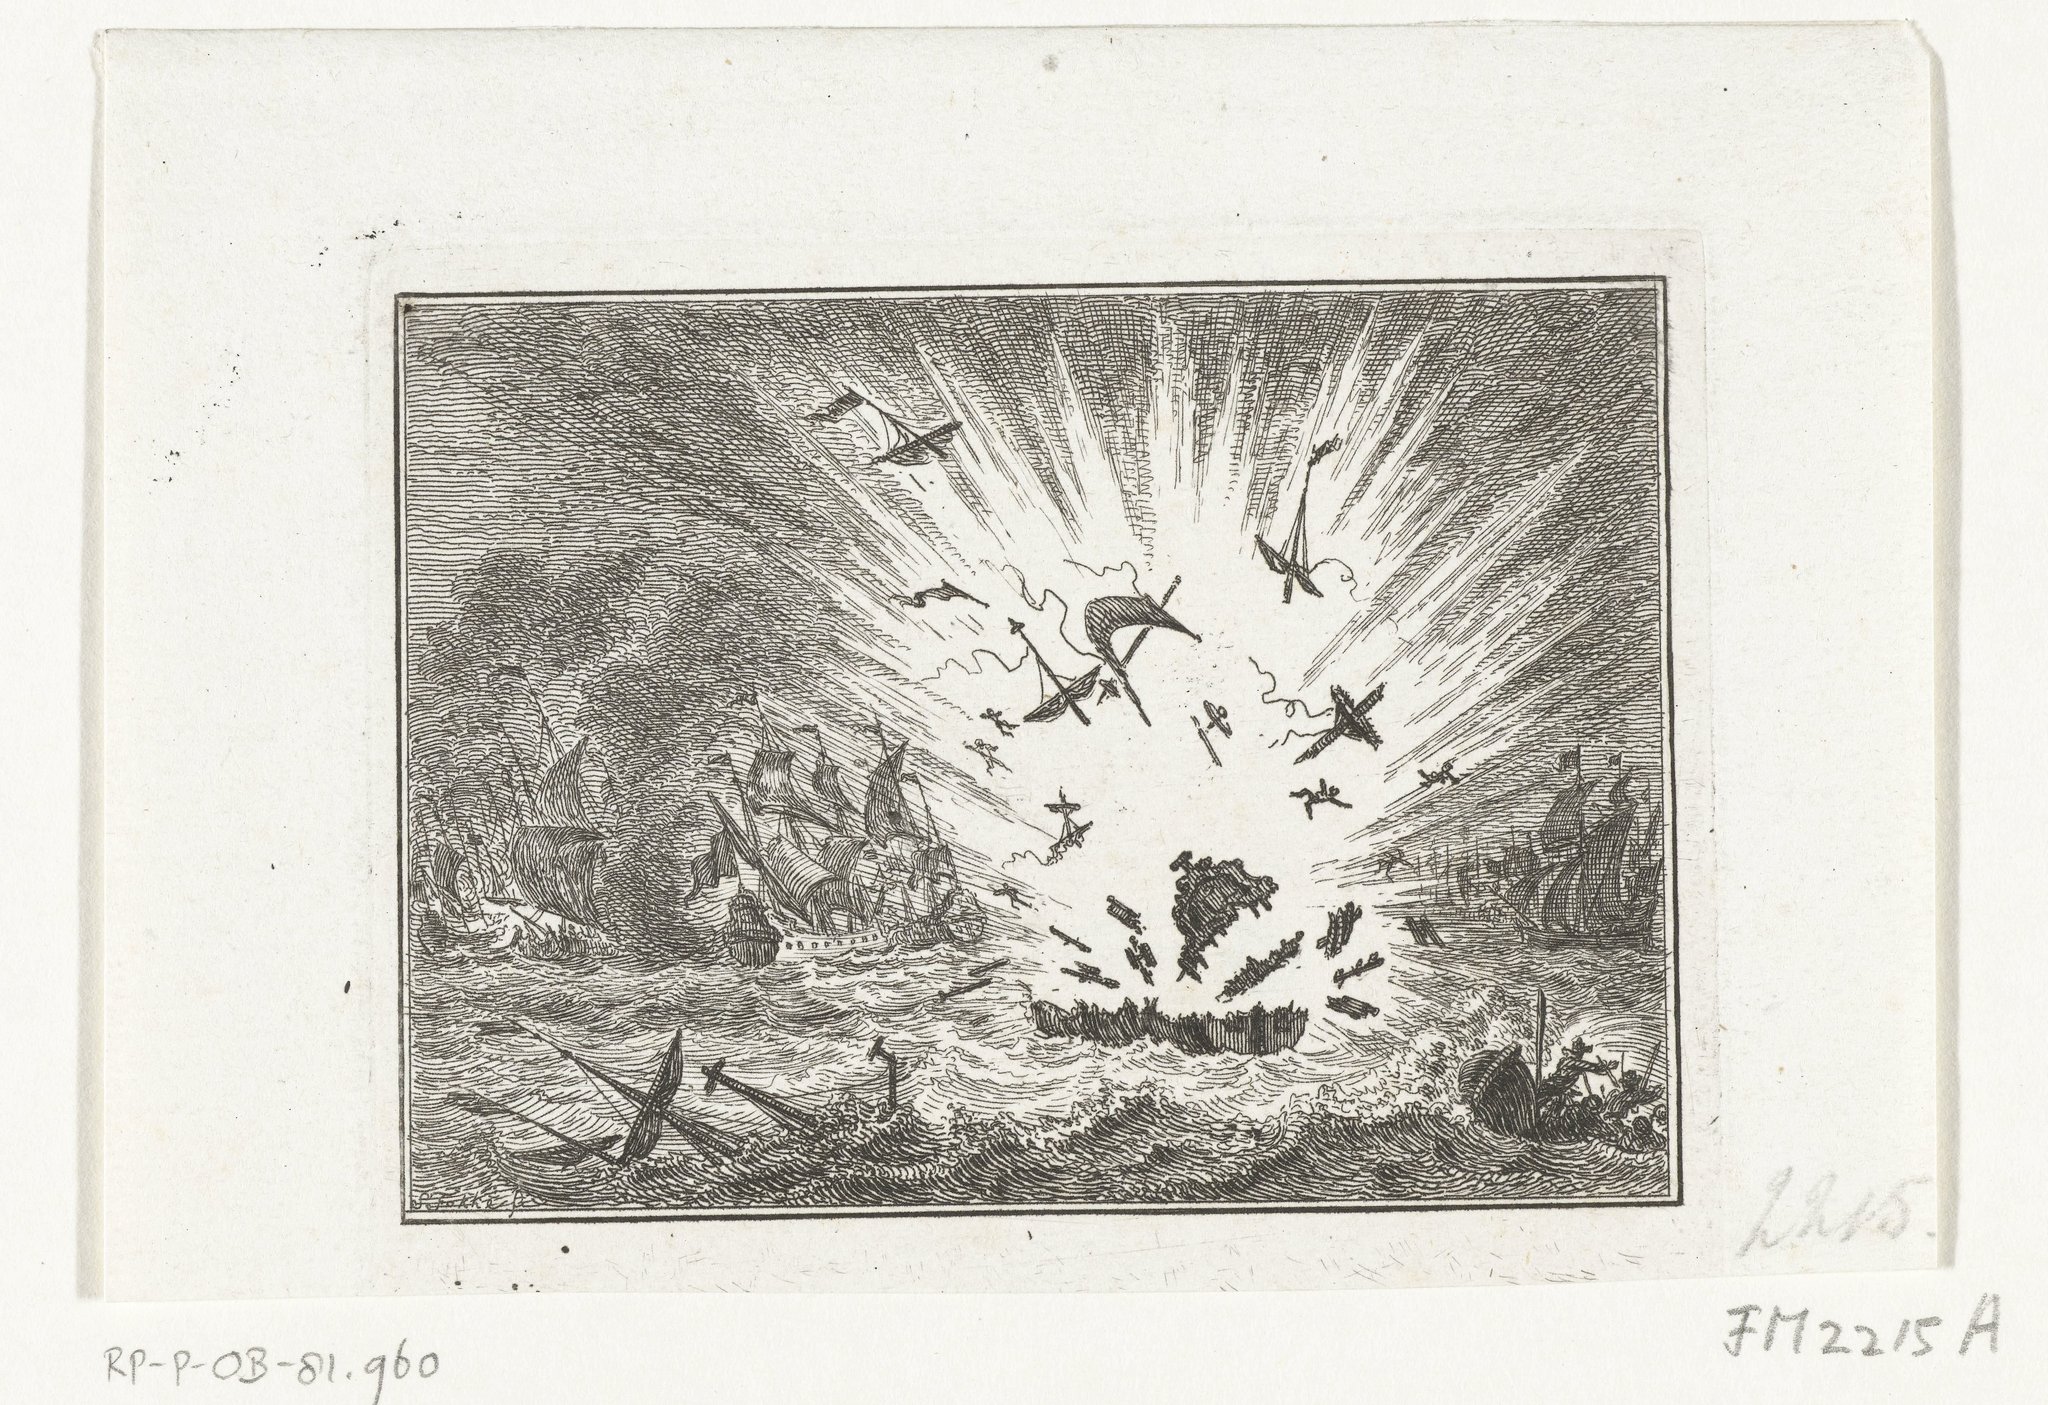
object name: print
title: Het ontploffen van de Eendracht tijdens de zeeslag bij Lowestoft, 1665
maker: simon fokke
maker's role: draughtsman, print maker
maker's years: 1712-1784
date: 1782-1784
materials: paper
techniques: etching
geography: northern netherlands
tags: james stuart (hertog van york), jacob baron van wassenaer heer van obdam, battle (+ naval force), battle of lowestoft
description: Gebruikt als illustratie in: J.W. te Water, De vaderlandsche Historie van den heere J. Wagenaar, verkort, en met leerzaame aanmerkingen, ten dienste der Nederlandsche jeugd, 1784-1800, 4 delen. Dit nummer is een door het RPK toegevoegd nummer en staat niet in Frederik Muller, het werk waar de prent voor is gemaakt of uit afkomstig is, staat wel vermeld in Frederik Muller.